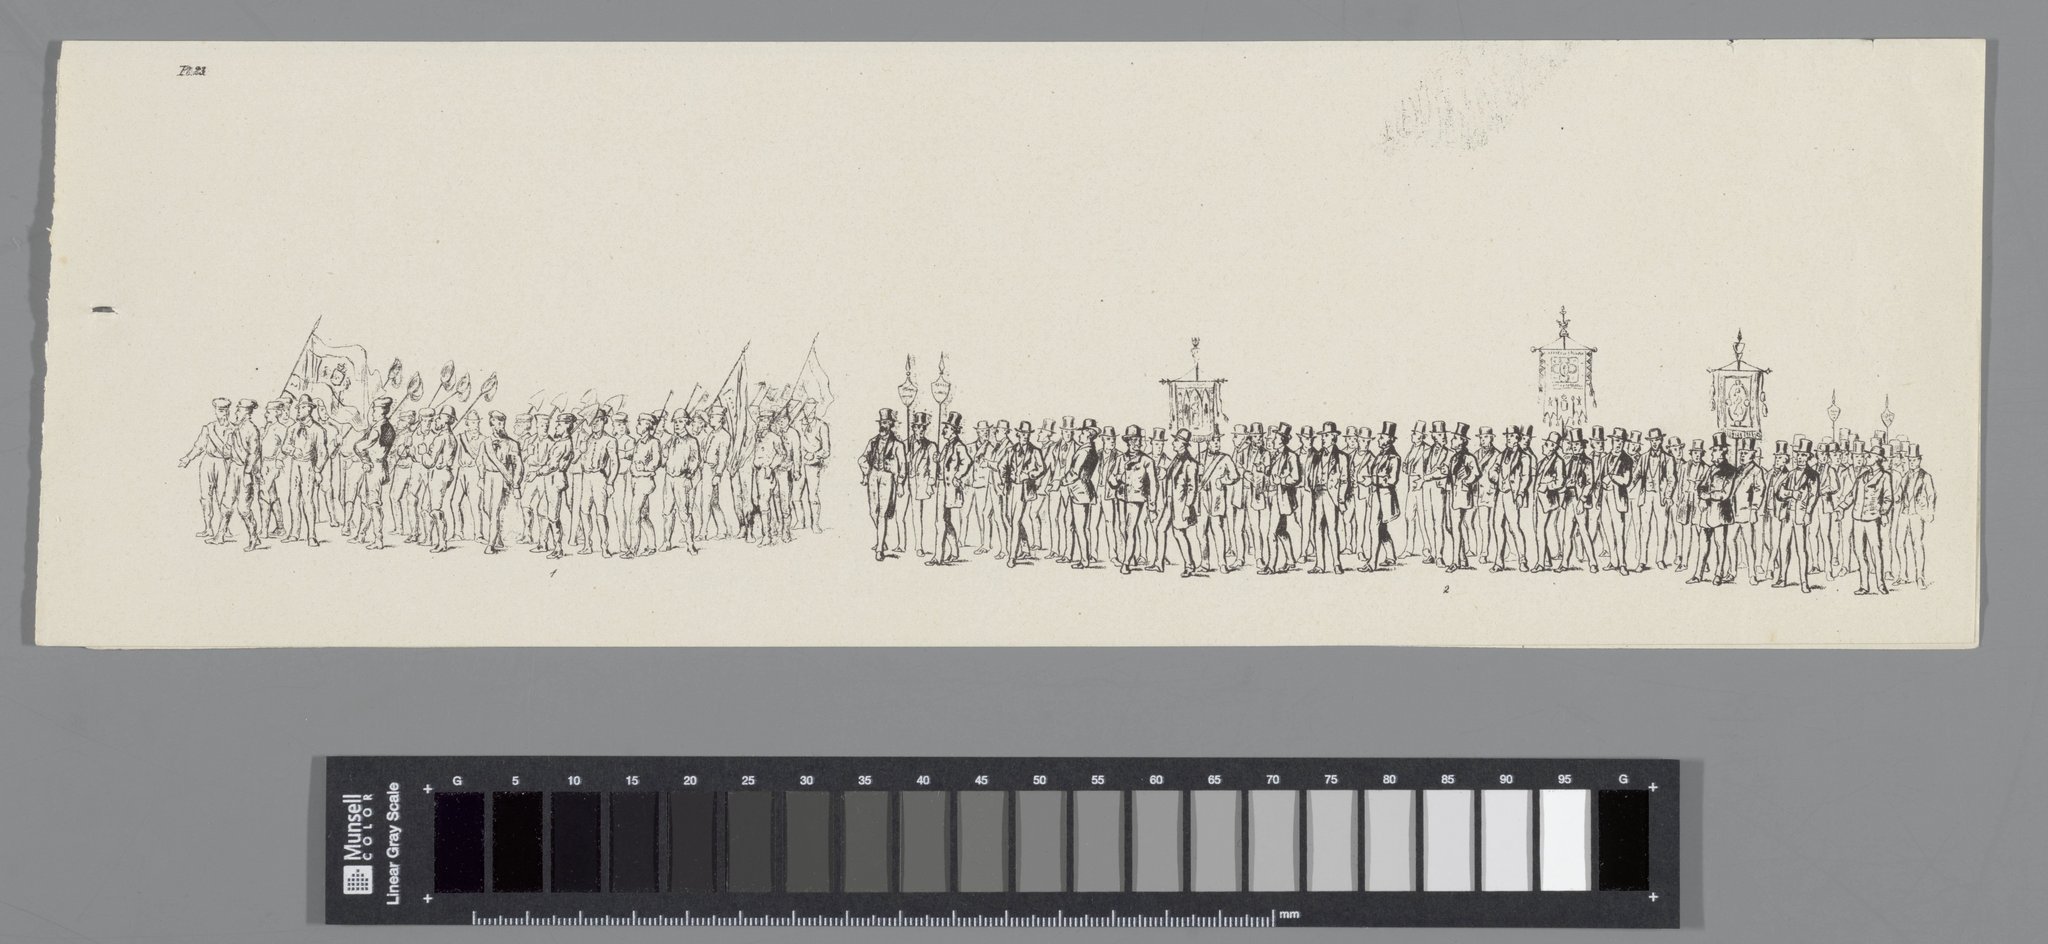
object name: print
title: Plaat 23. - Fig. 1. De Nederlandsche Gravers- en Baggerlieden Vereeniging (...) De St. Jozefs Gezellen-Vereeniging (...) Leden van de Bazenvereeniging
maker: Anonymous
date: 1874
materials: paper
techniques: lithograph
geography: amsterdam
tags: brussels, willem iii (koning der nederlanden), public festivities at other royal events, not meant or mentioned above (+ parade, pageant, cavalcade ~ festive activities), modern professional organization, trade union, amsterdam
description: Plaat nr. 23 met het deel van de optocht met leden van de verschillende vakverenigingen. Onderdeel van een serie van 24 platen van de gekostumeerde historische en allegorische optocht gehouden te Amsterdam op 12 mei 1874, als onderdeel van de feestelijkheden tijdens de viering van het 25-jarige regeringsjubileum van koning Willem III.